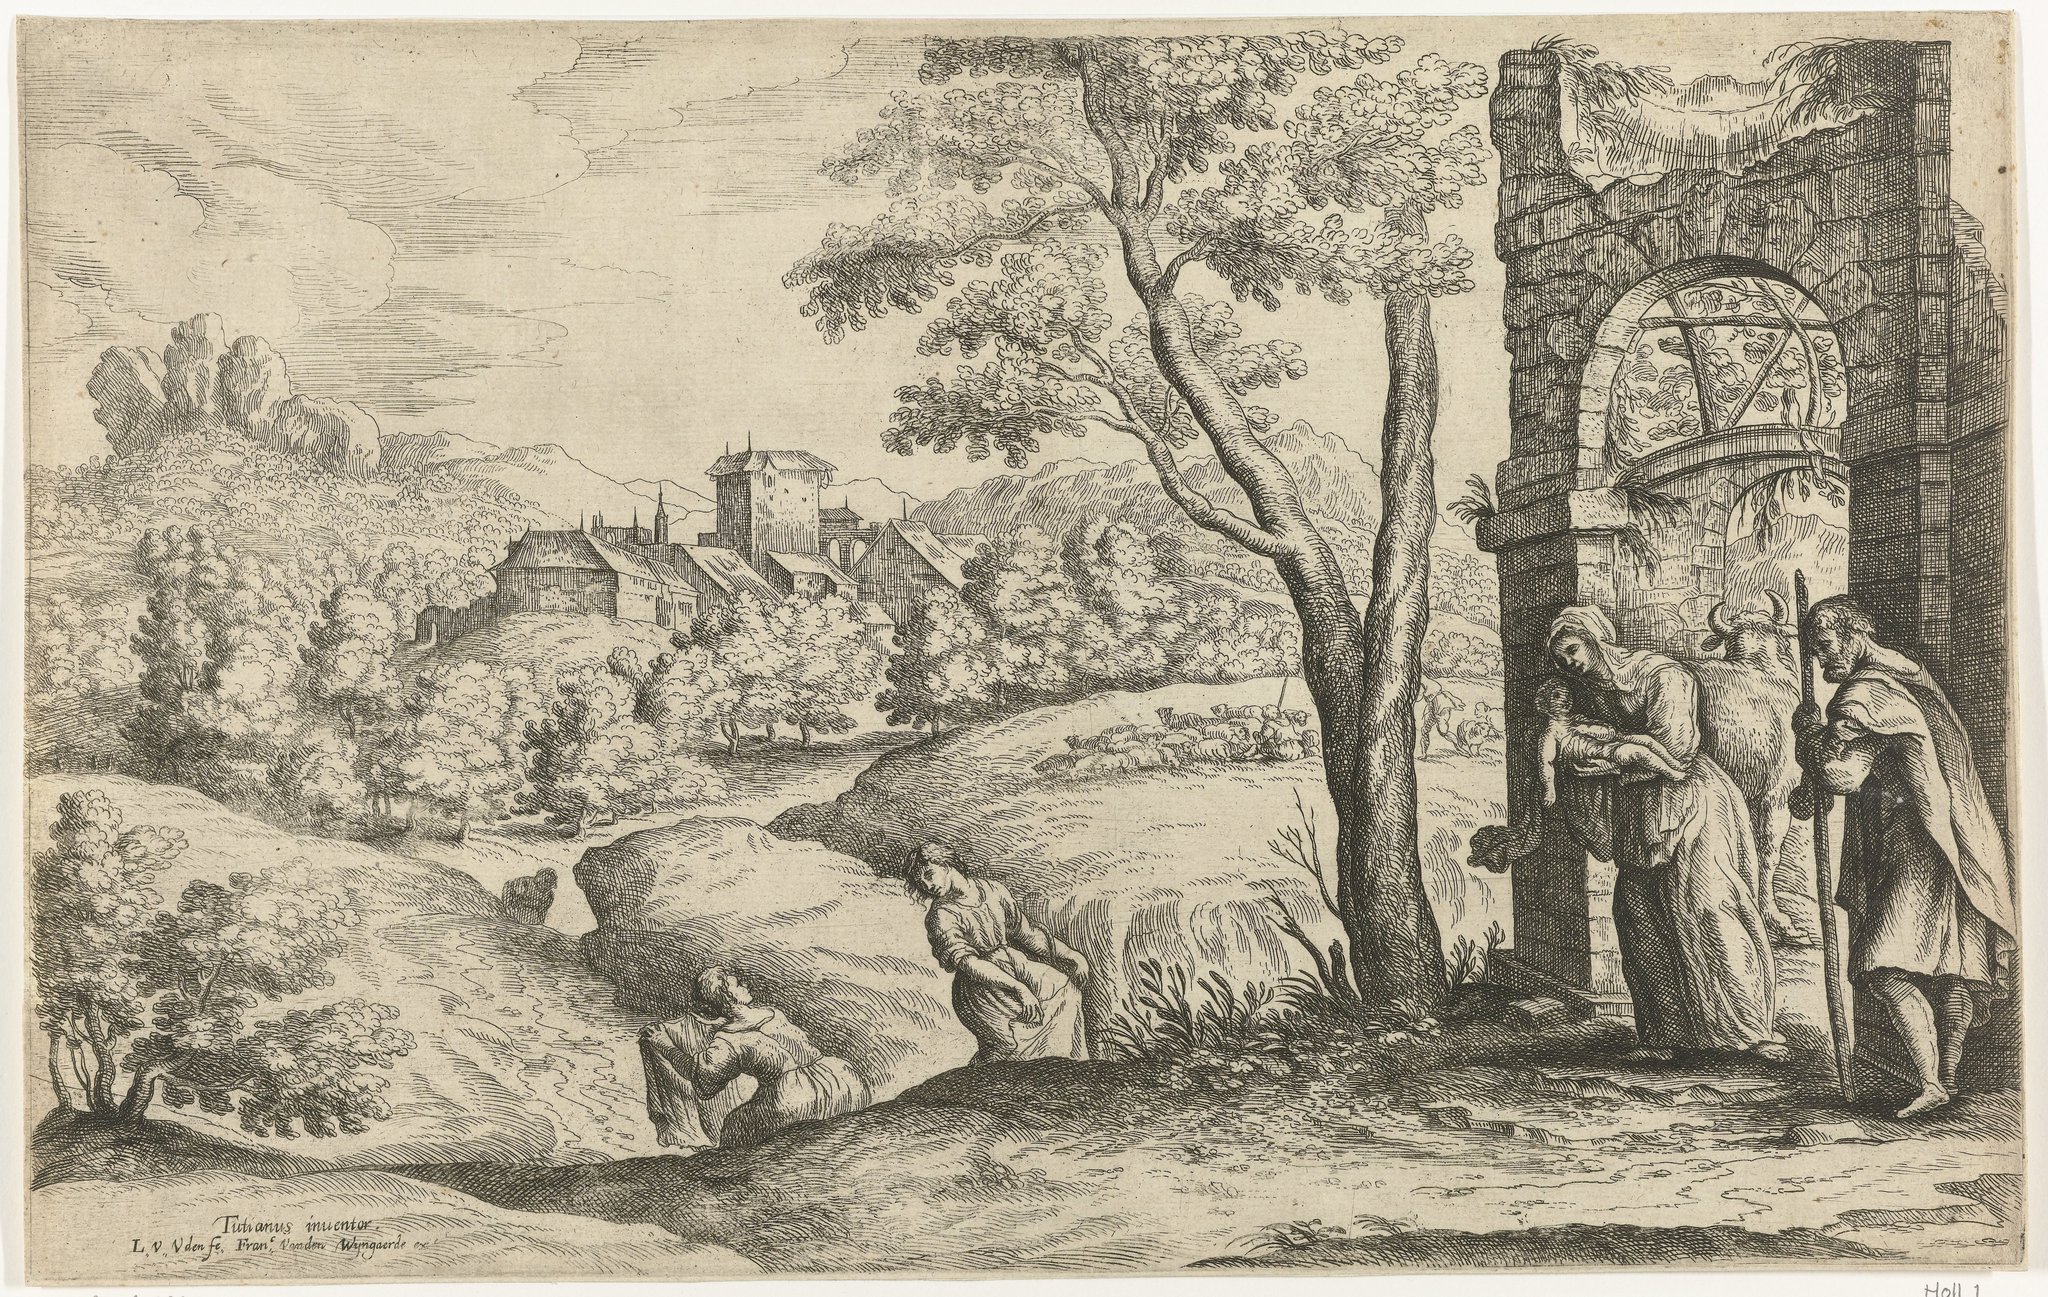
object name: print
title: Landschap met de heilige familie en twee vroedvrouwen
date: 1605-1673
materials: paper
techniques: engraving, etching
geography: low countries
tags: midwife, 'accoucheuse', mary, joseph and the new-born christ (nativity)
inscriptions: collector's mark: Lugt 2228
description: Landschap met een ruïne met Maria, het Christuskind, Jozef en de os. Twee vrouwen wassen lakens in een beek.